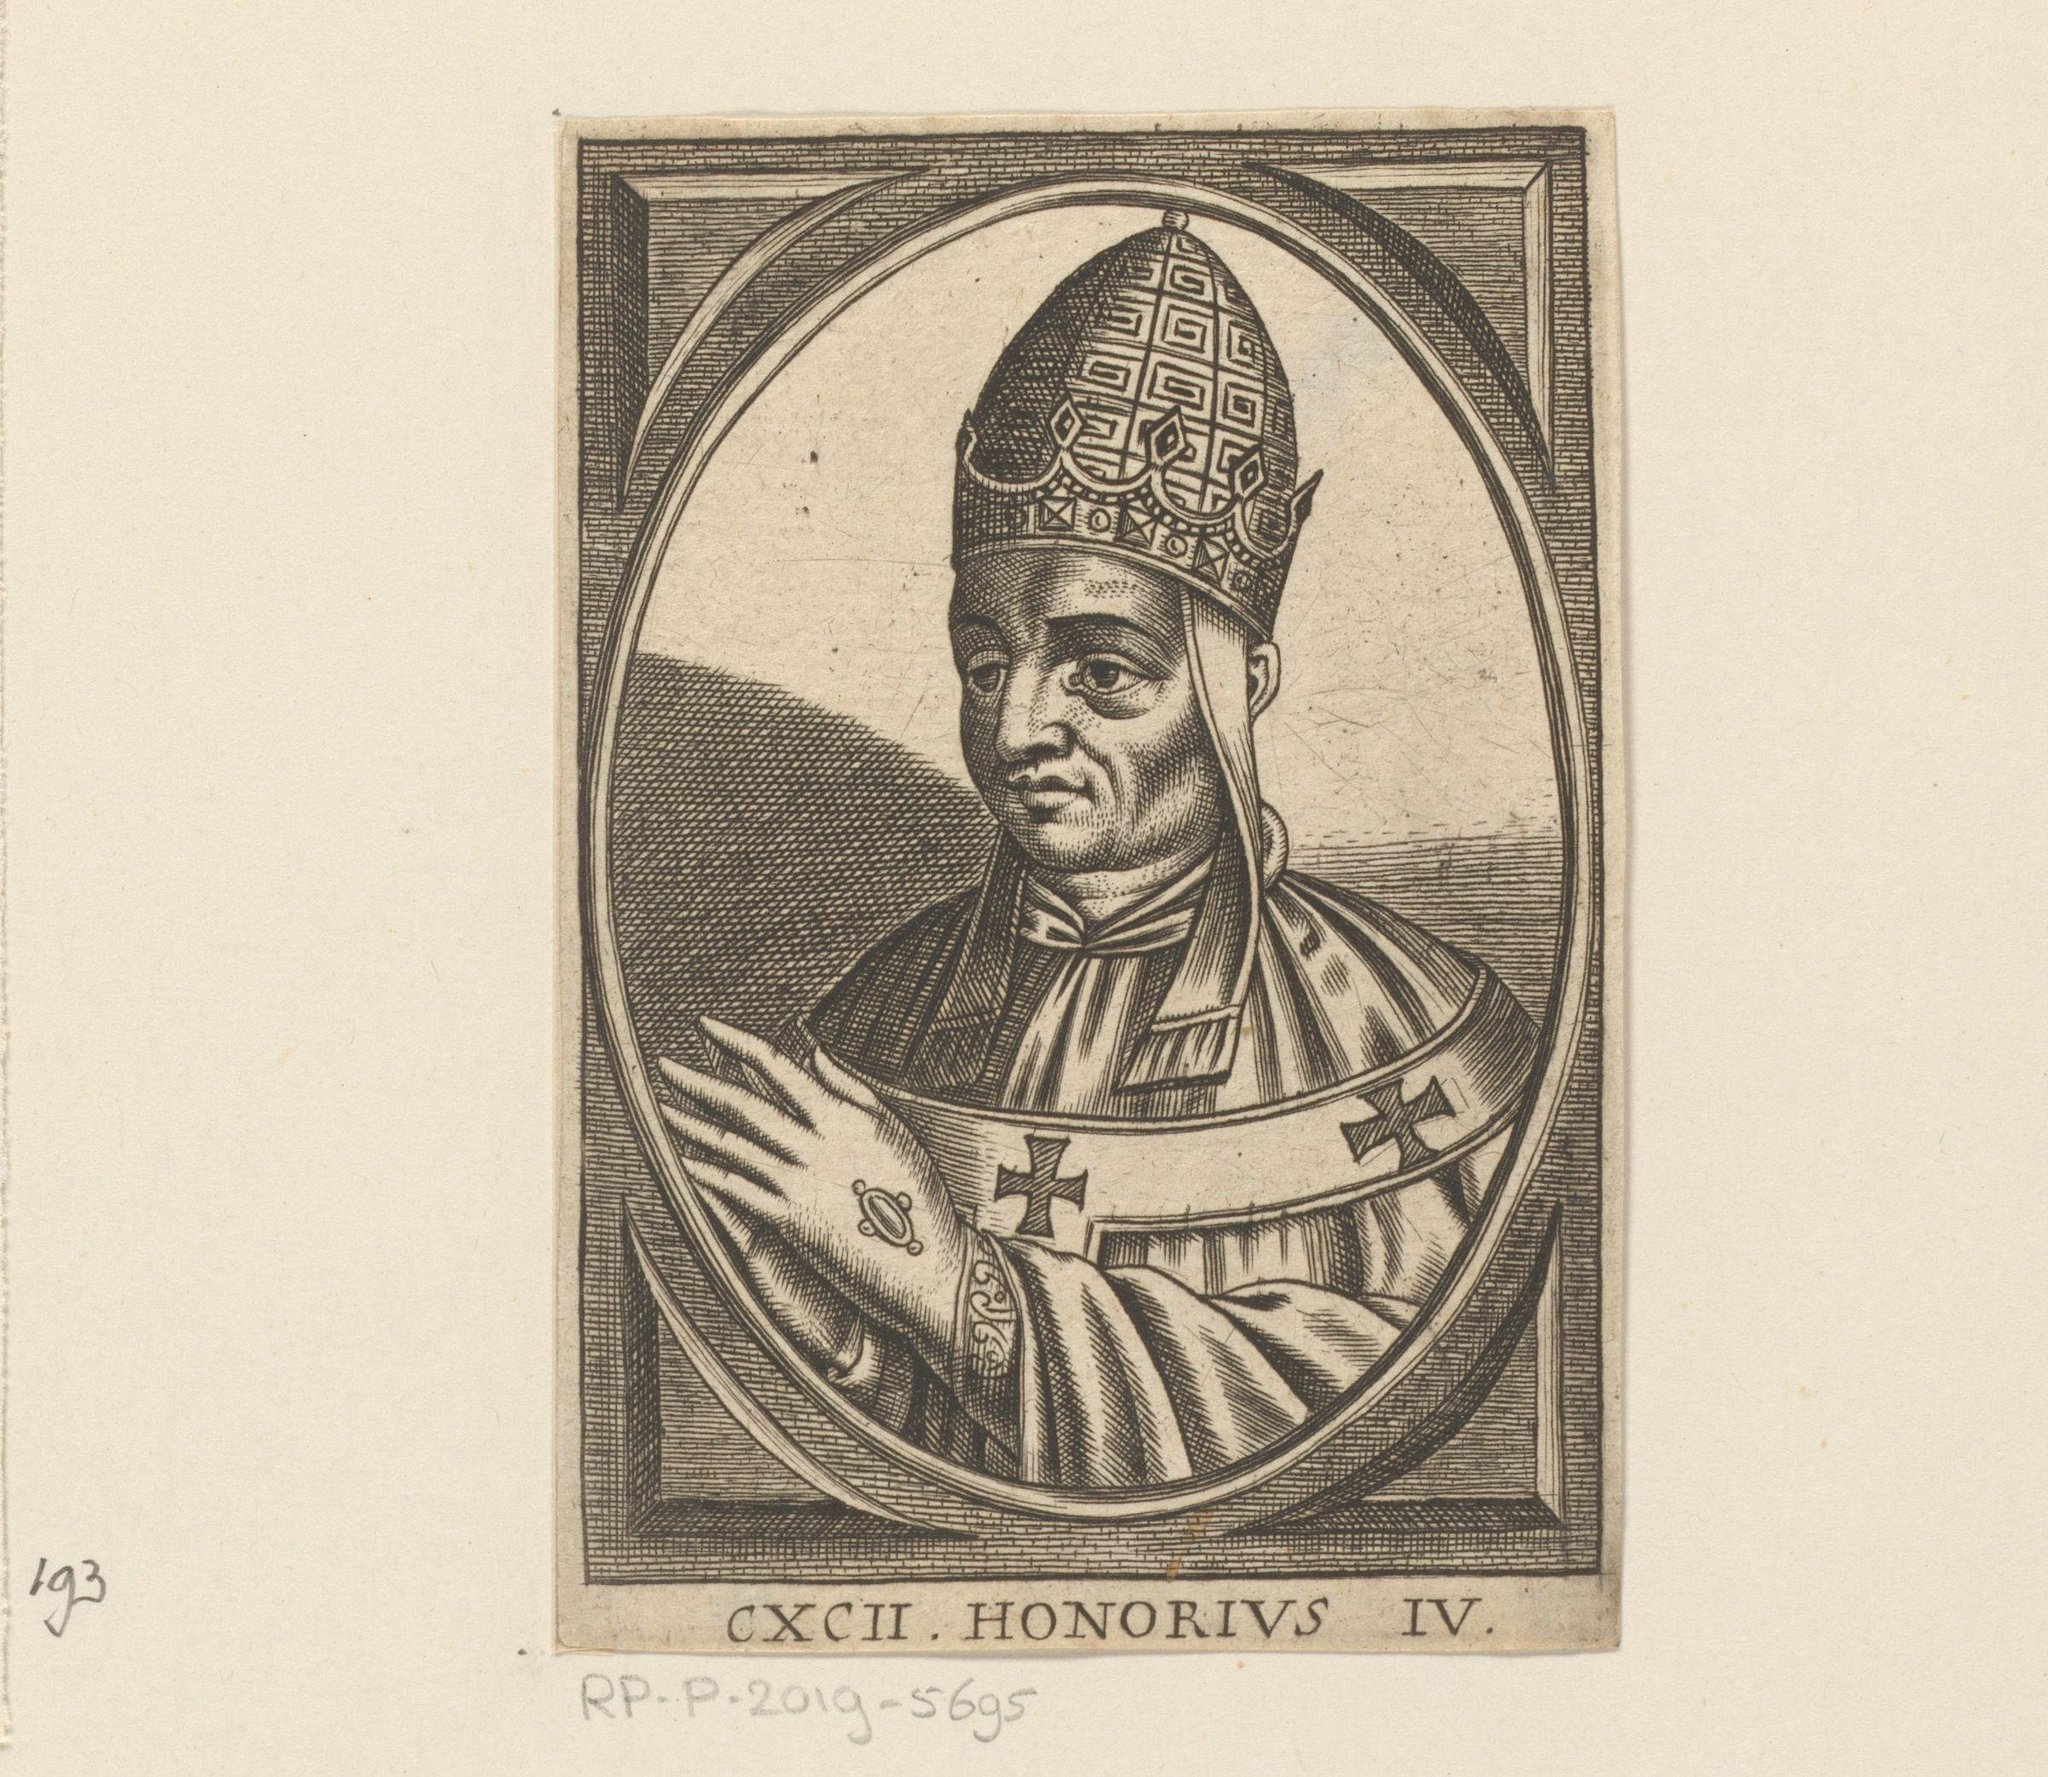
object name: print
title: Portret van paus Honorius IV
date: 1679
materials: paper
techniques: engraving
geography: antwerp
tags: historical persons, pope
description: Prent uit: Hazart, Cornelius. Triomph der pausen van Roomen over alle hare benyders ende bestryders (...). Antwerpen: Michiel Cnobbaert, 1679, dl. 2. Prent ook gebruikt in andere publicaties van deze uitgever. Zie bijvoorbeeld: Propylaeum ad acta sanctorum maii sub felicissimus auspiciis Innocentii XI (...). Antwerpen: Michiel Cnobbaert, s.a.